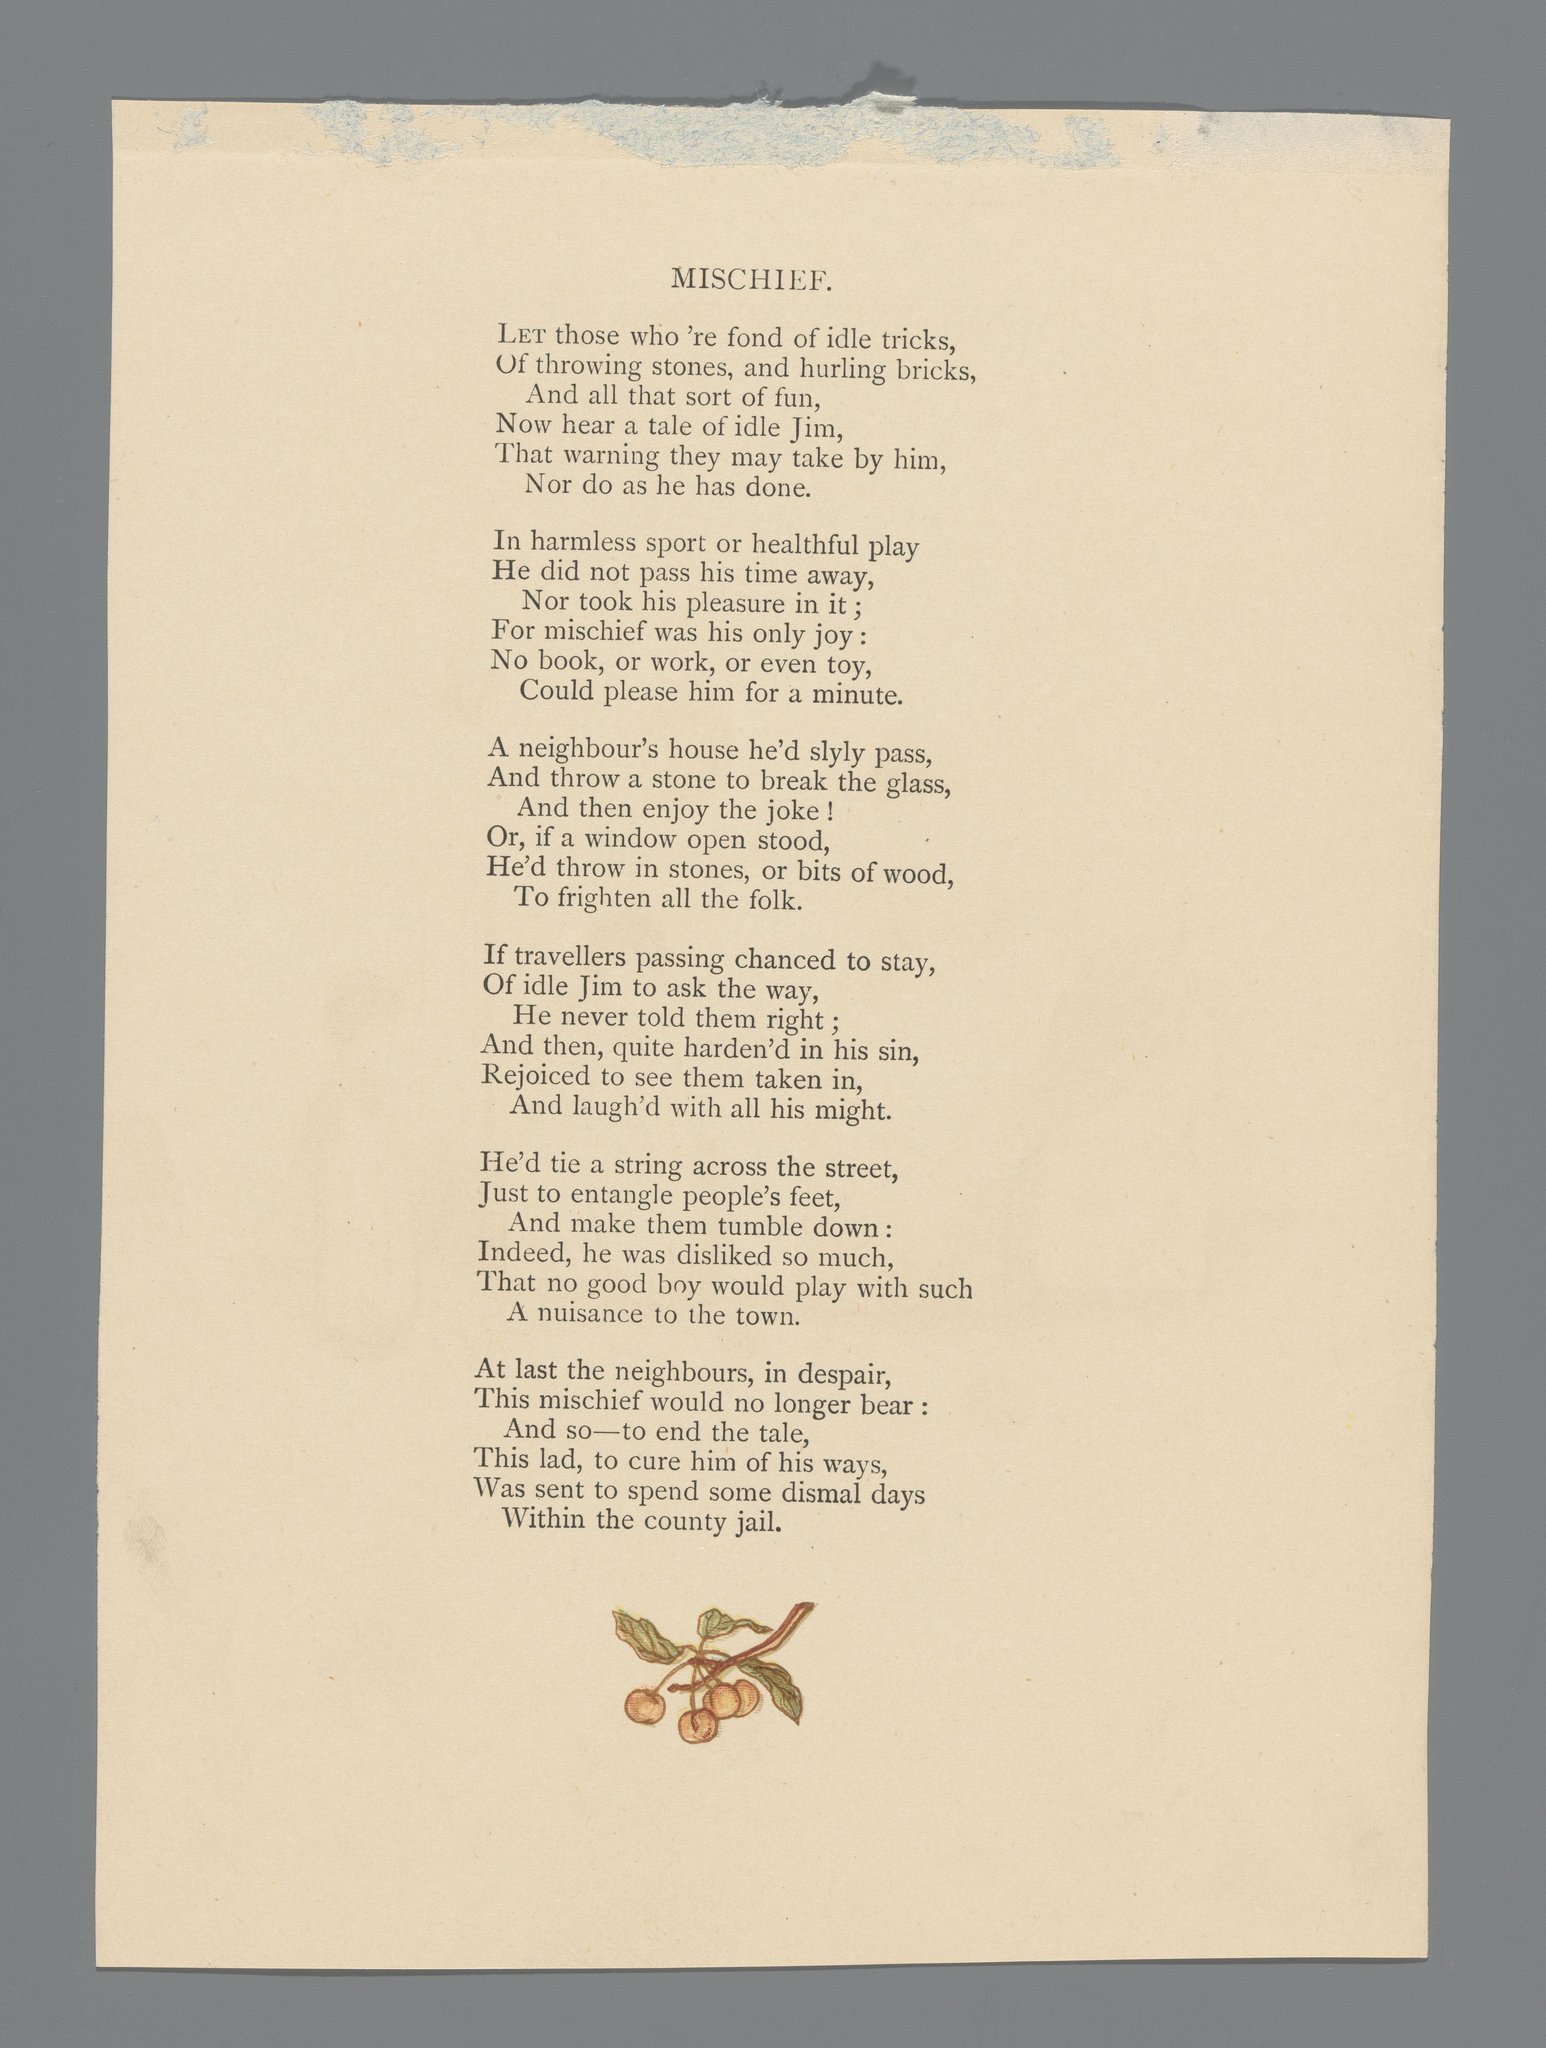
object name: print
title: Kersen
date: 1883-1927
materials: paper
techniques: wood engraving, letterpress printing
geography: london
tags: fruits: cherry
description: Prent uit: Jane en Ann Taylor. Little Ann and other poems. Londen: George Routledge & Sons, [1883], p. 61. Of een latere uitgave.